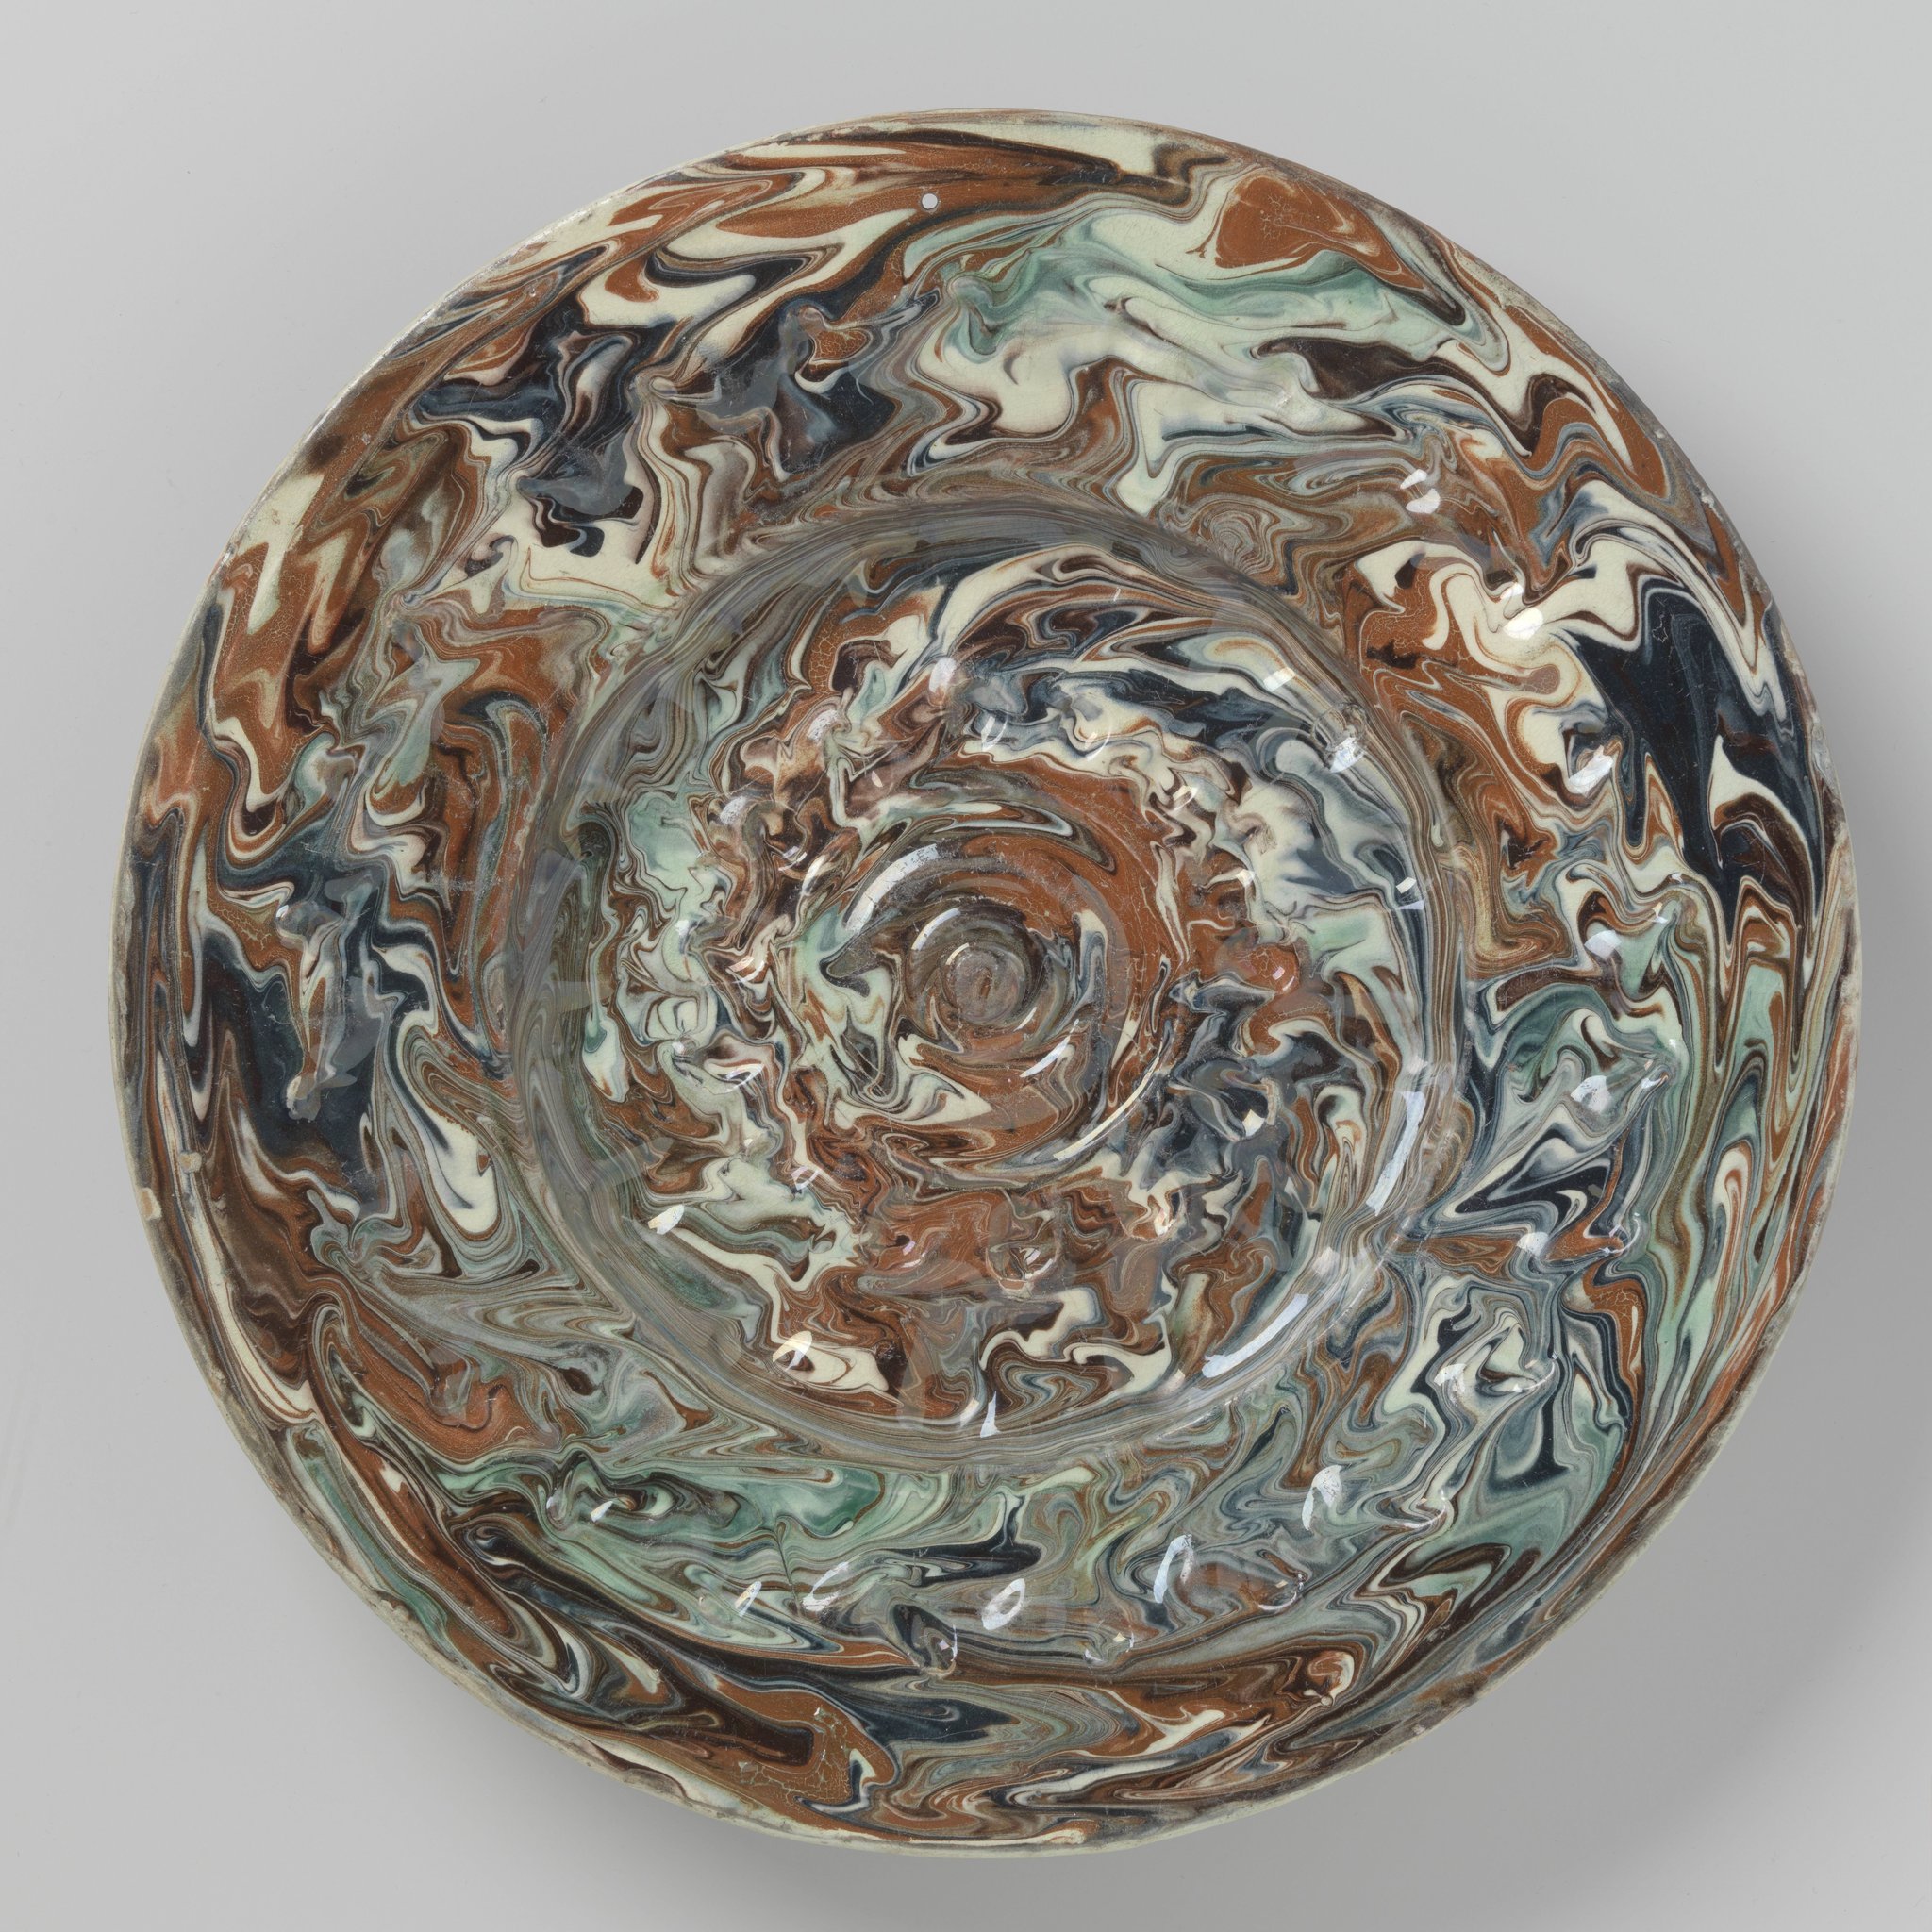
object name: platter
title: Schotel van loodglazuur aardewerk, met verdiept plat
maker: Anonymous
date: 1575-1625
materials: earthenware, glaze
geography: italy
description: Schotel van loodglazuur aardewerk. Het plat is verdiept en versierd met drie concentrische cirkels in relief, waar omheen twee cirkelvormig gerangschikte reeksen van kuiltjes. De brede rand heeft een reeks noppen afgewisseld met kuiltjes. De schotel is bedekt met roodbruine, blauwe, groene en paarse en geelwitte sliblagen die geschud zijn. De achterkant is bedekt met bruine, roodbruine en geelwitte geschudde sliblagen.